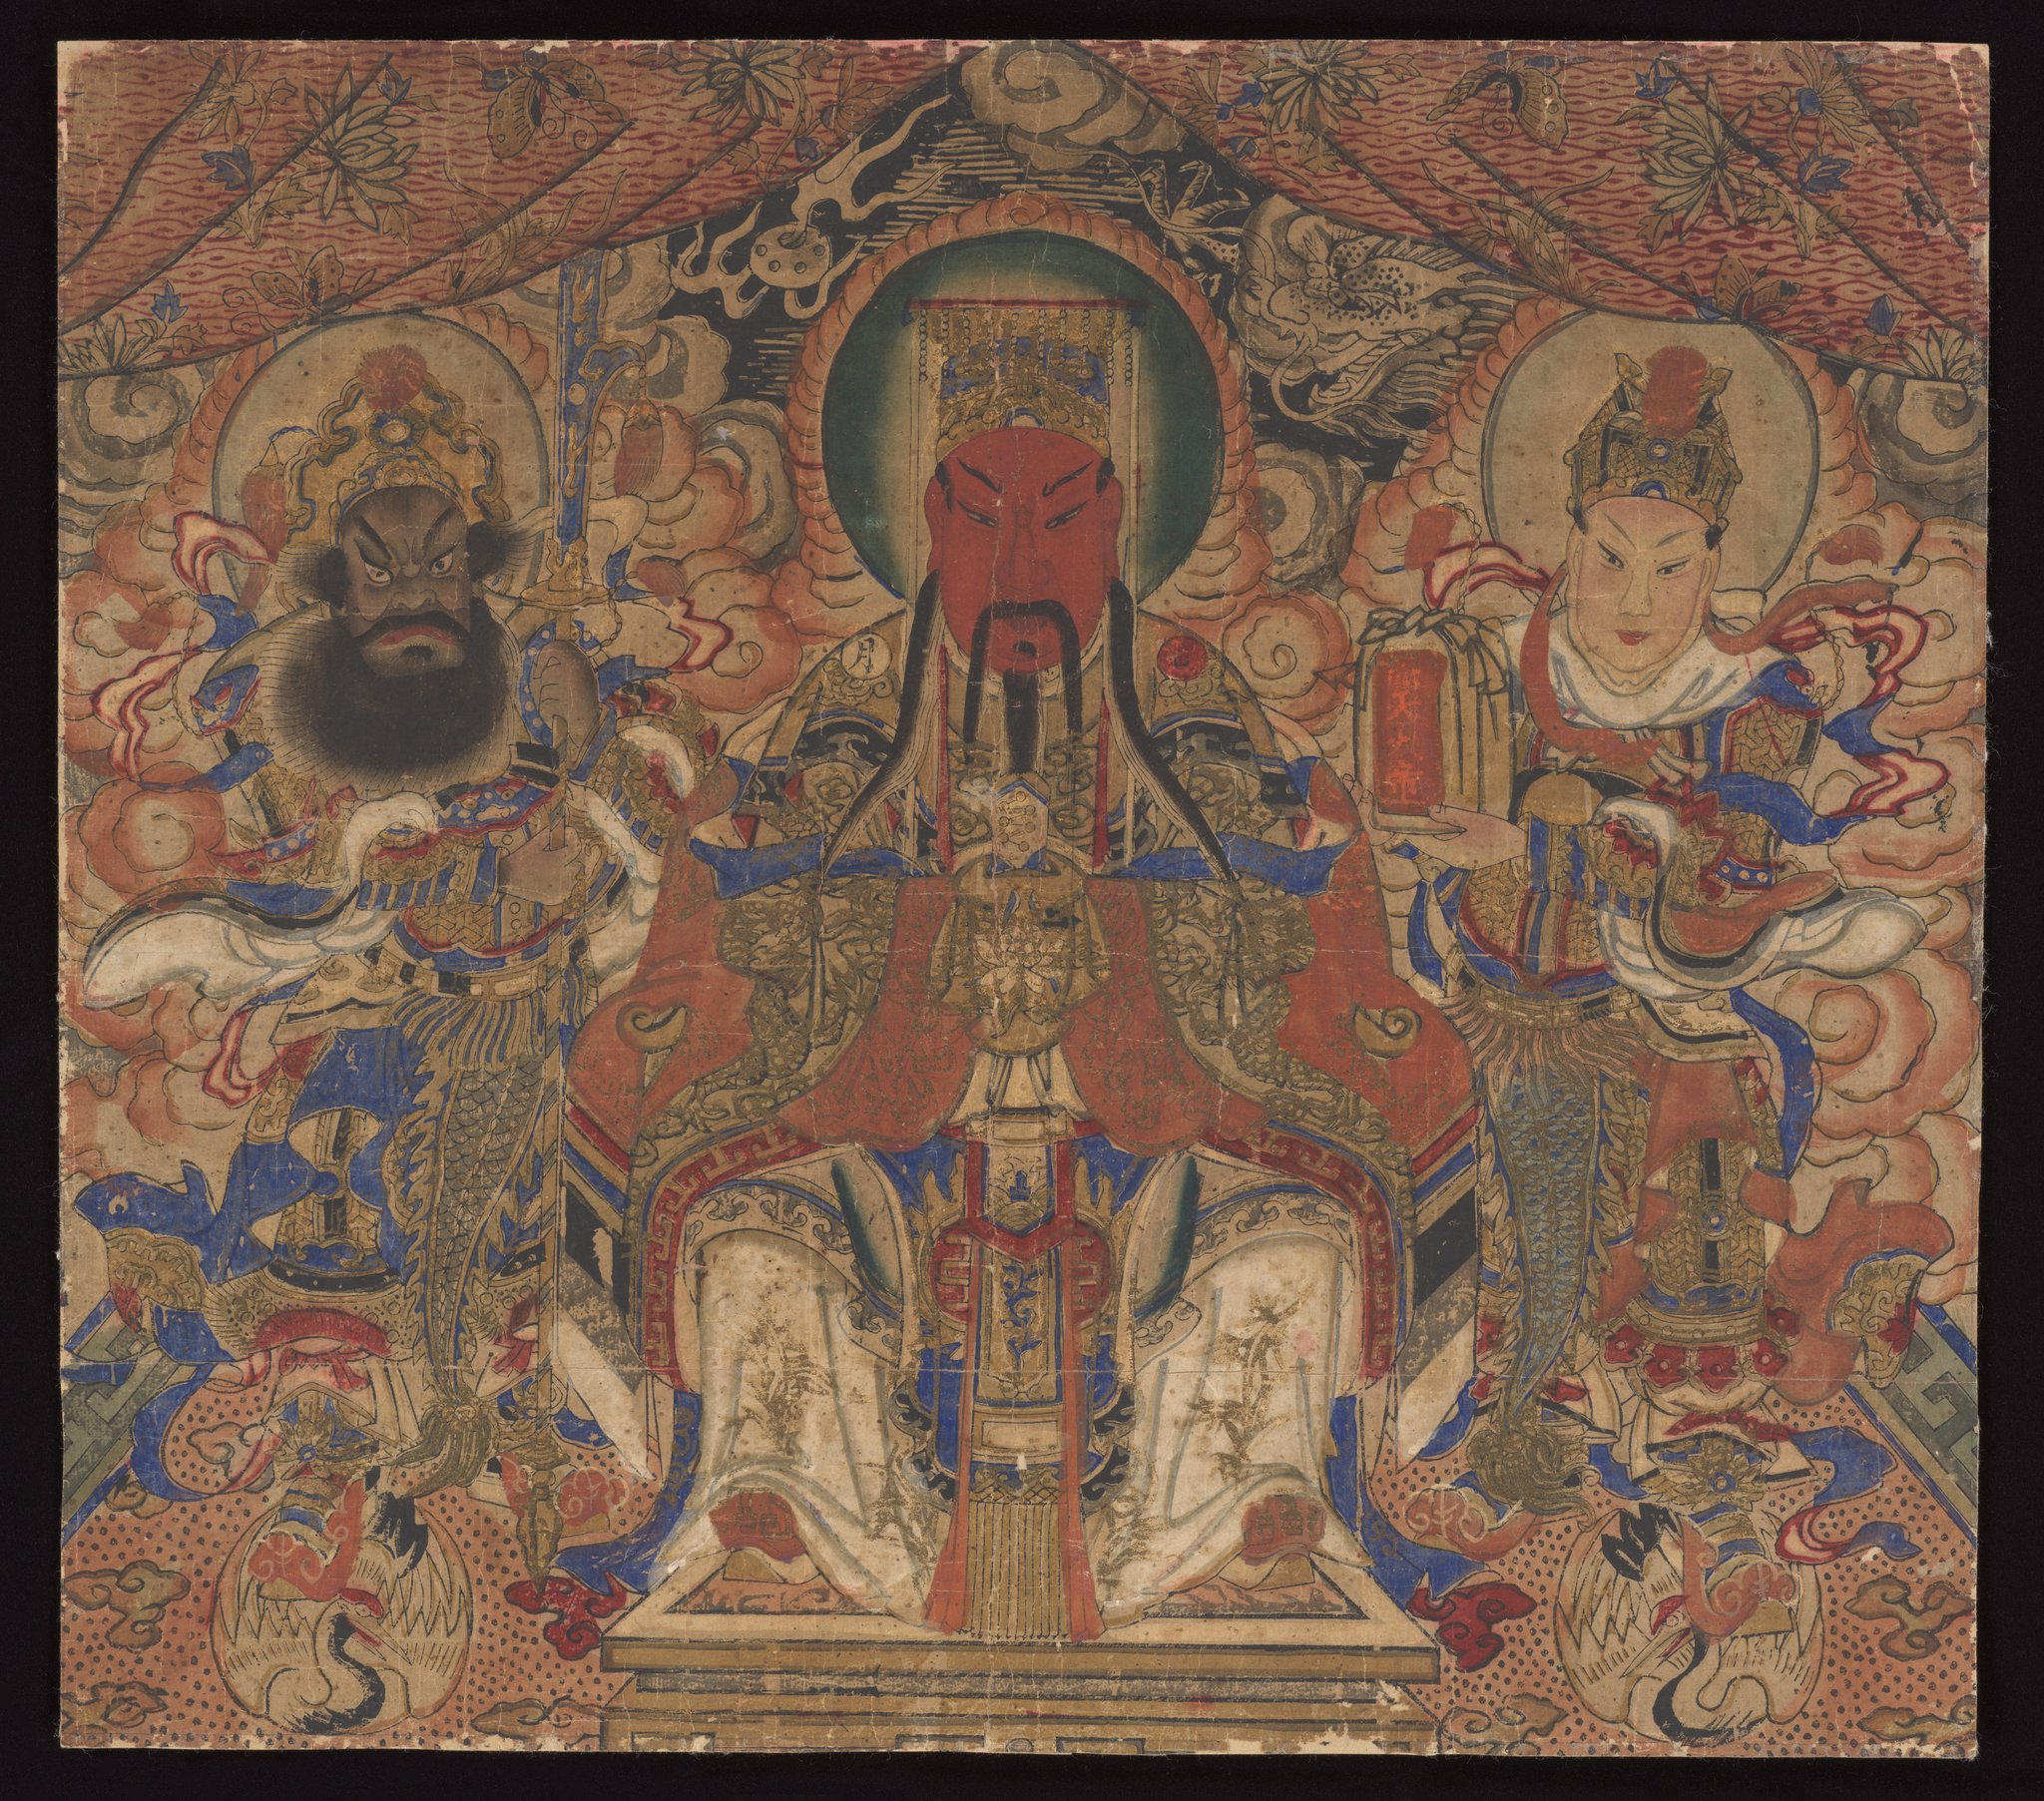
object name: print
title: The Holy Emperor Lord Guan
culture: chinese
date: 1368-1644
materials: ink, paper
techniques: hand coloring, woodblock print